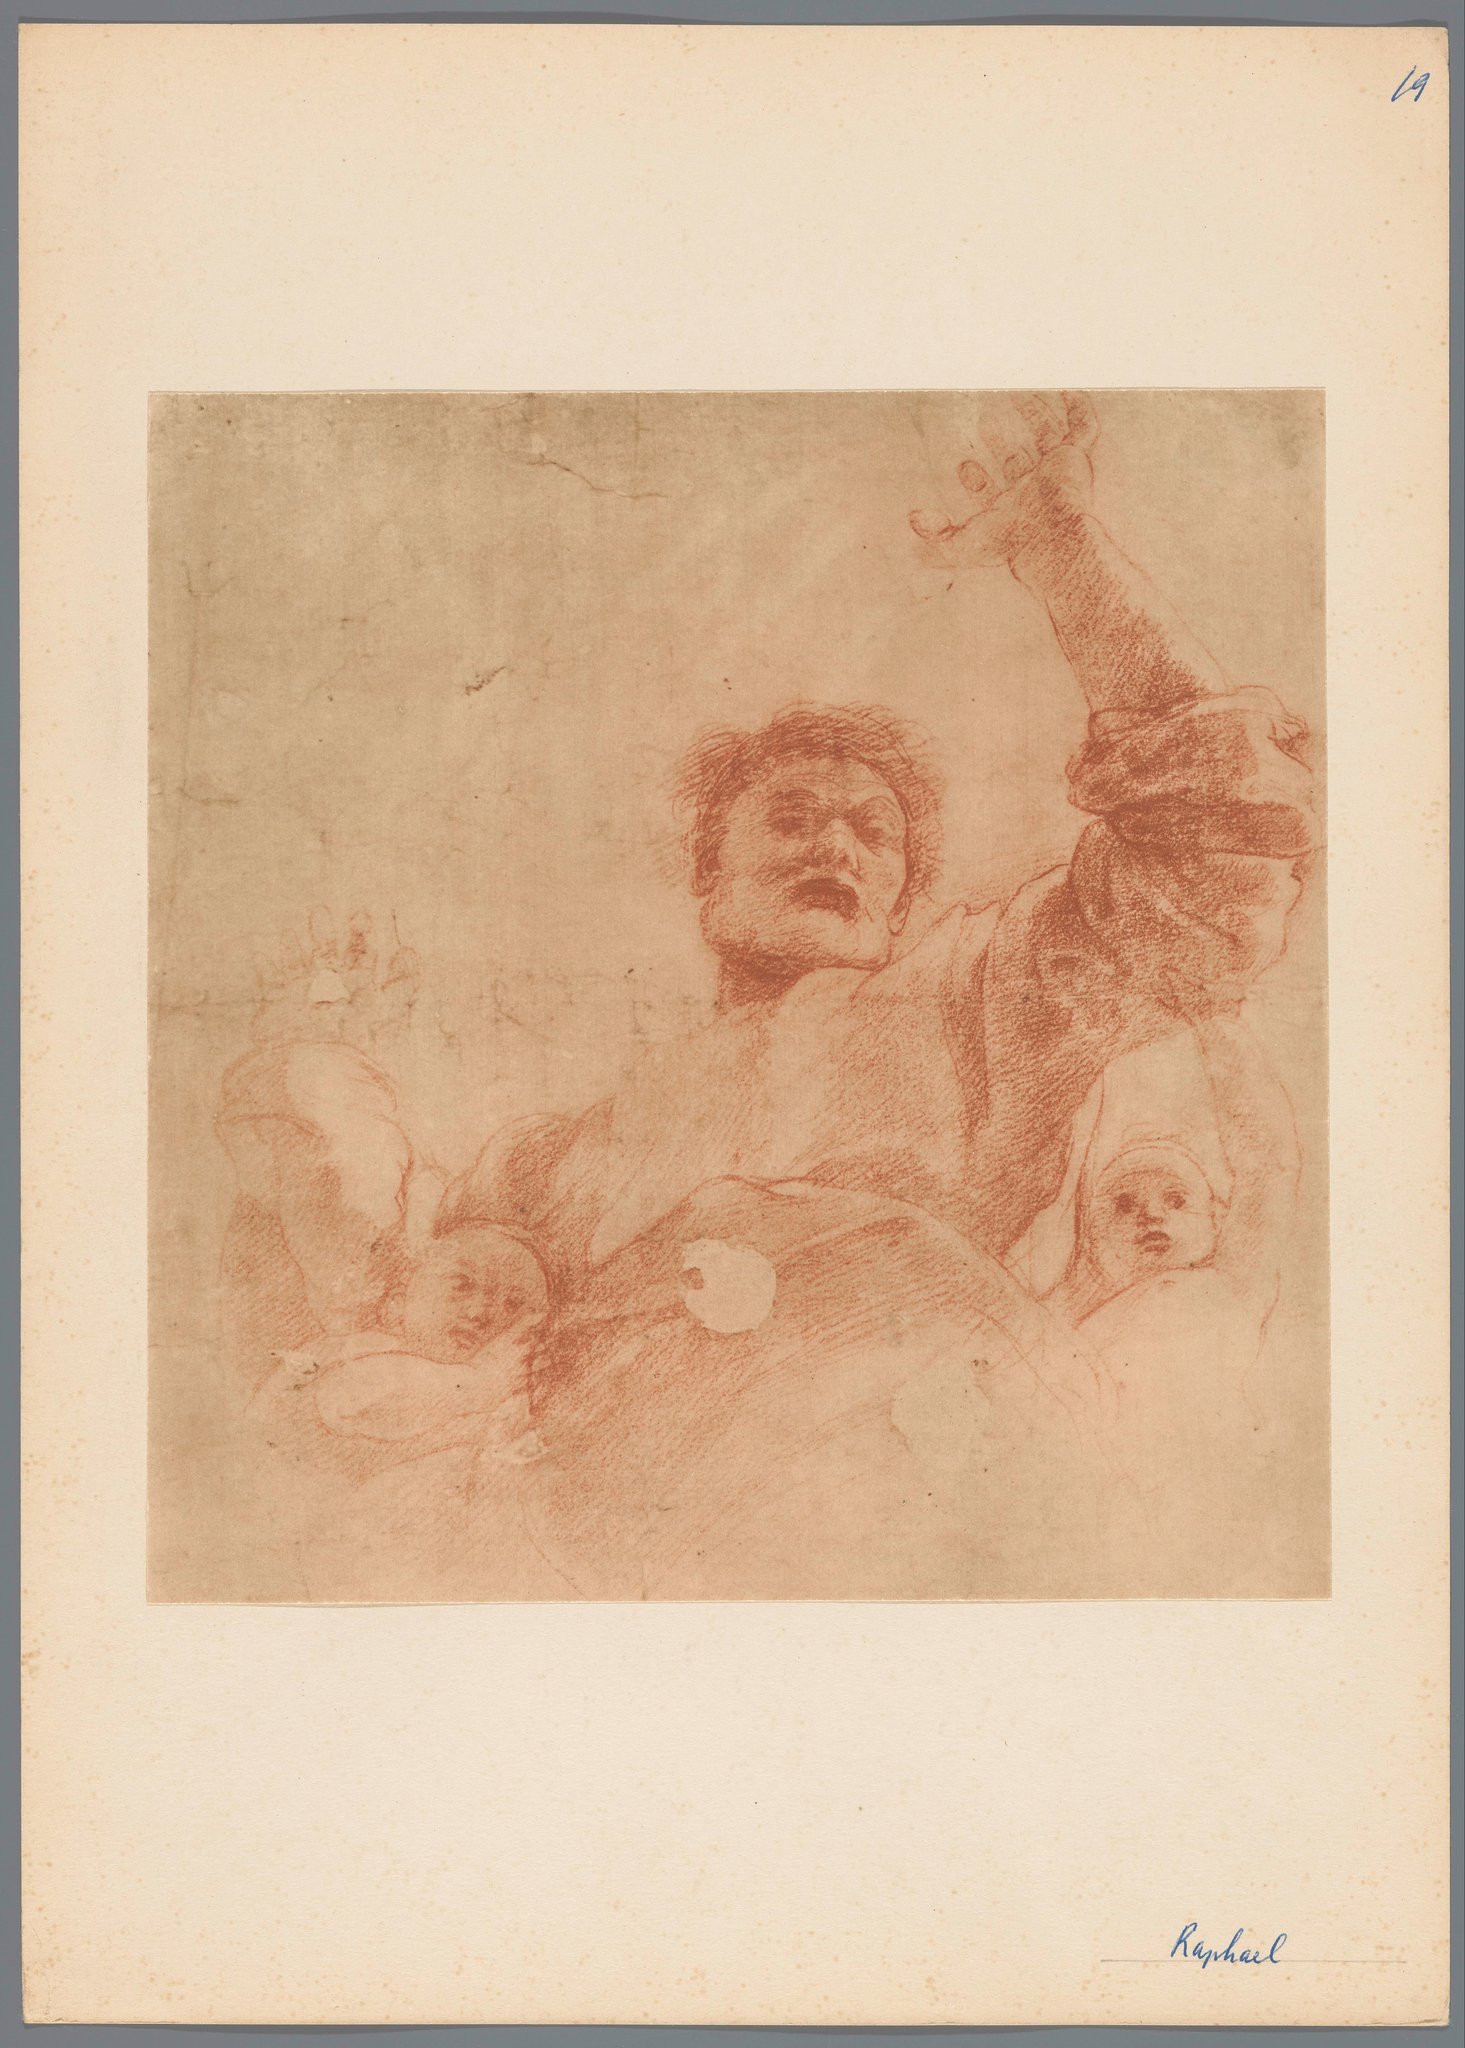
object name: reproduction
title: Reproductie van Studie van God de Vader van Rafaël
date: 1850-1950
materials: cardboard, paper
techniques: photograph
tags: god the father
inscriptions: number: ‘19’, collector's mark: ‘Instituut v. kunstn./ afd. opl tot teekenl.’, inscription: ‘Raphael/ Studie v. mozaiek in S. Maria del Popolo, Rome/ Ashmolean Mus Oxford/ zie andere studie zelfde onderw.’, inscription: ‘Raphael’